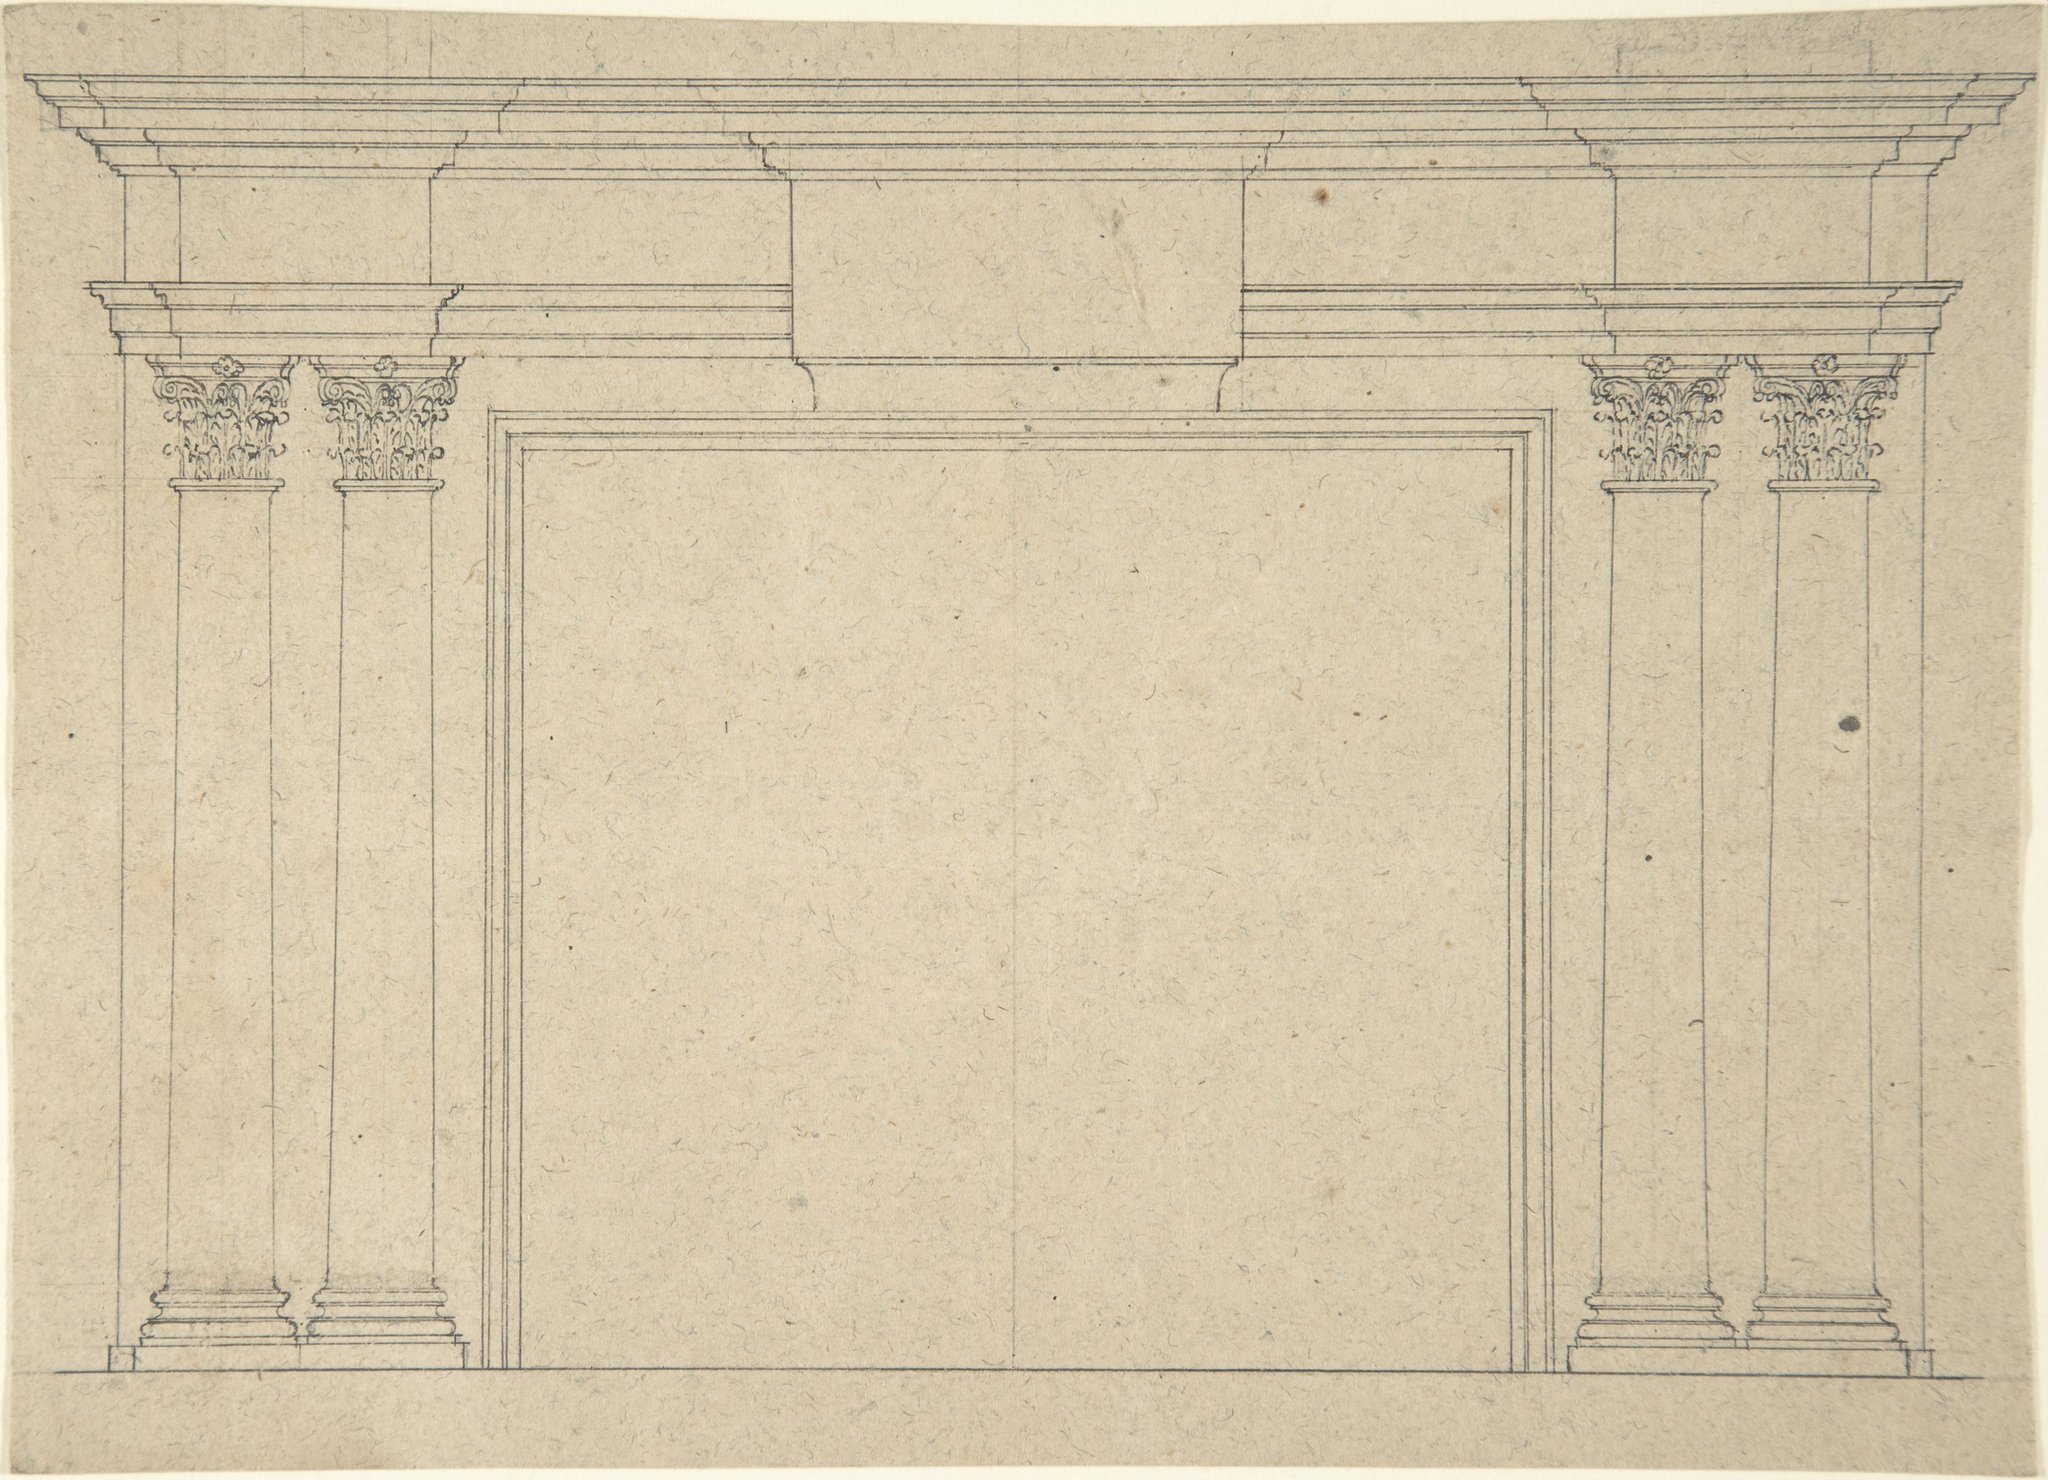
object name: drawing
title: Design for a Chimneypiece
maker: sir william chambers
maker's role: artist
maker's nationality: british, born sweden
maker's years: 1723-1796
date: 1740-1800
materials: ink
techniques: pen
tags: fireplaces